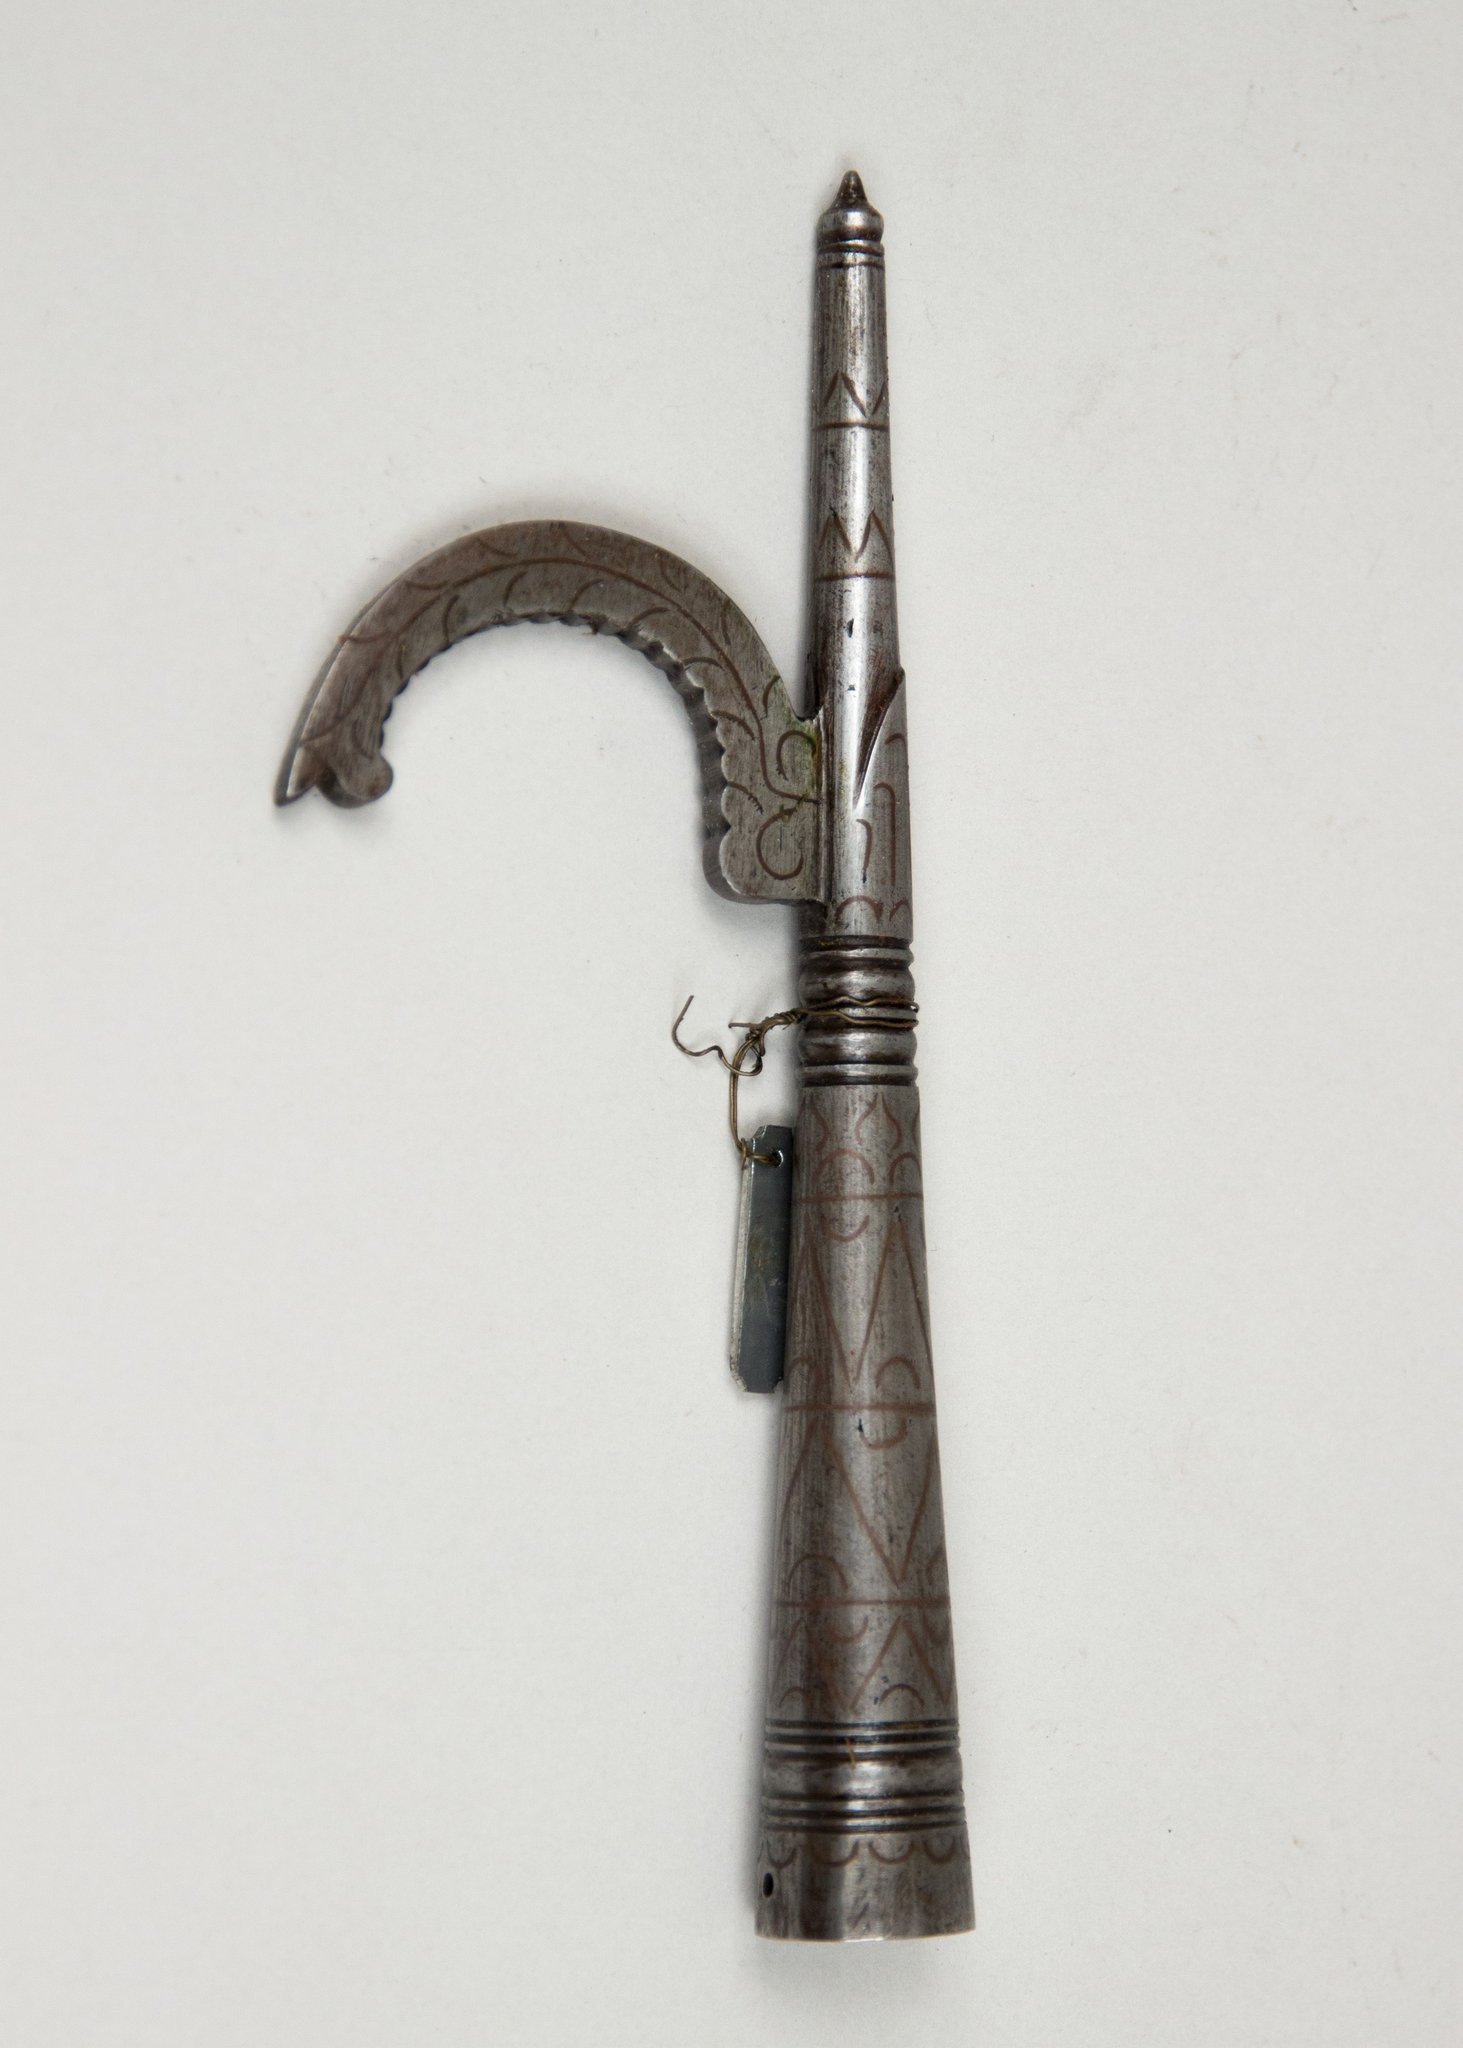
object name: ancus head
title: Head of an Ancus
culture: sri lankan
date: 1701-1900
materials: silver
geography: sri lanka